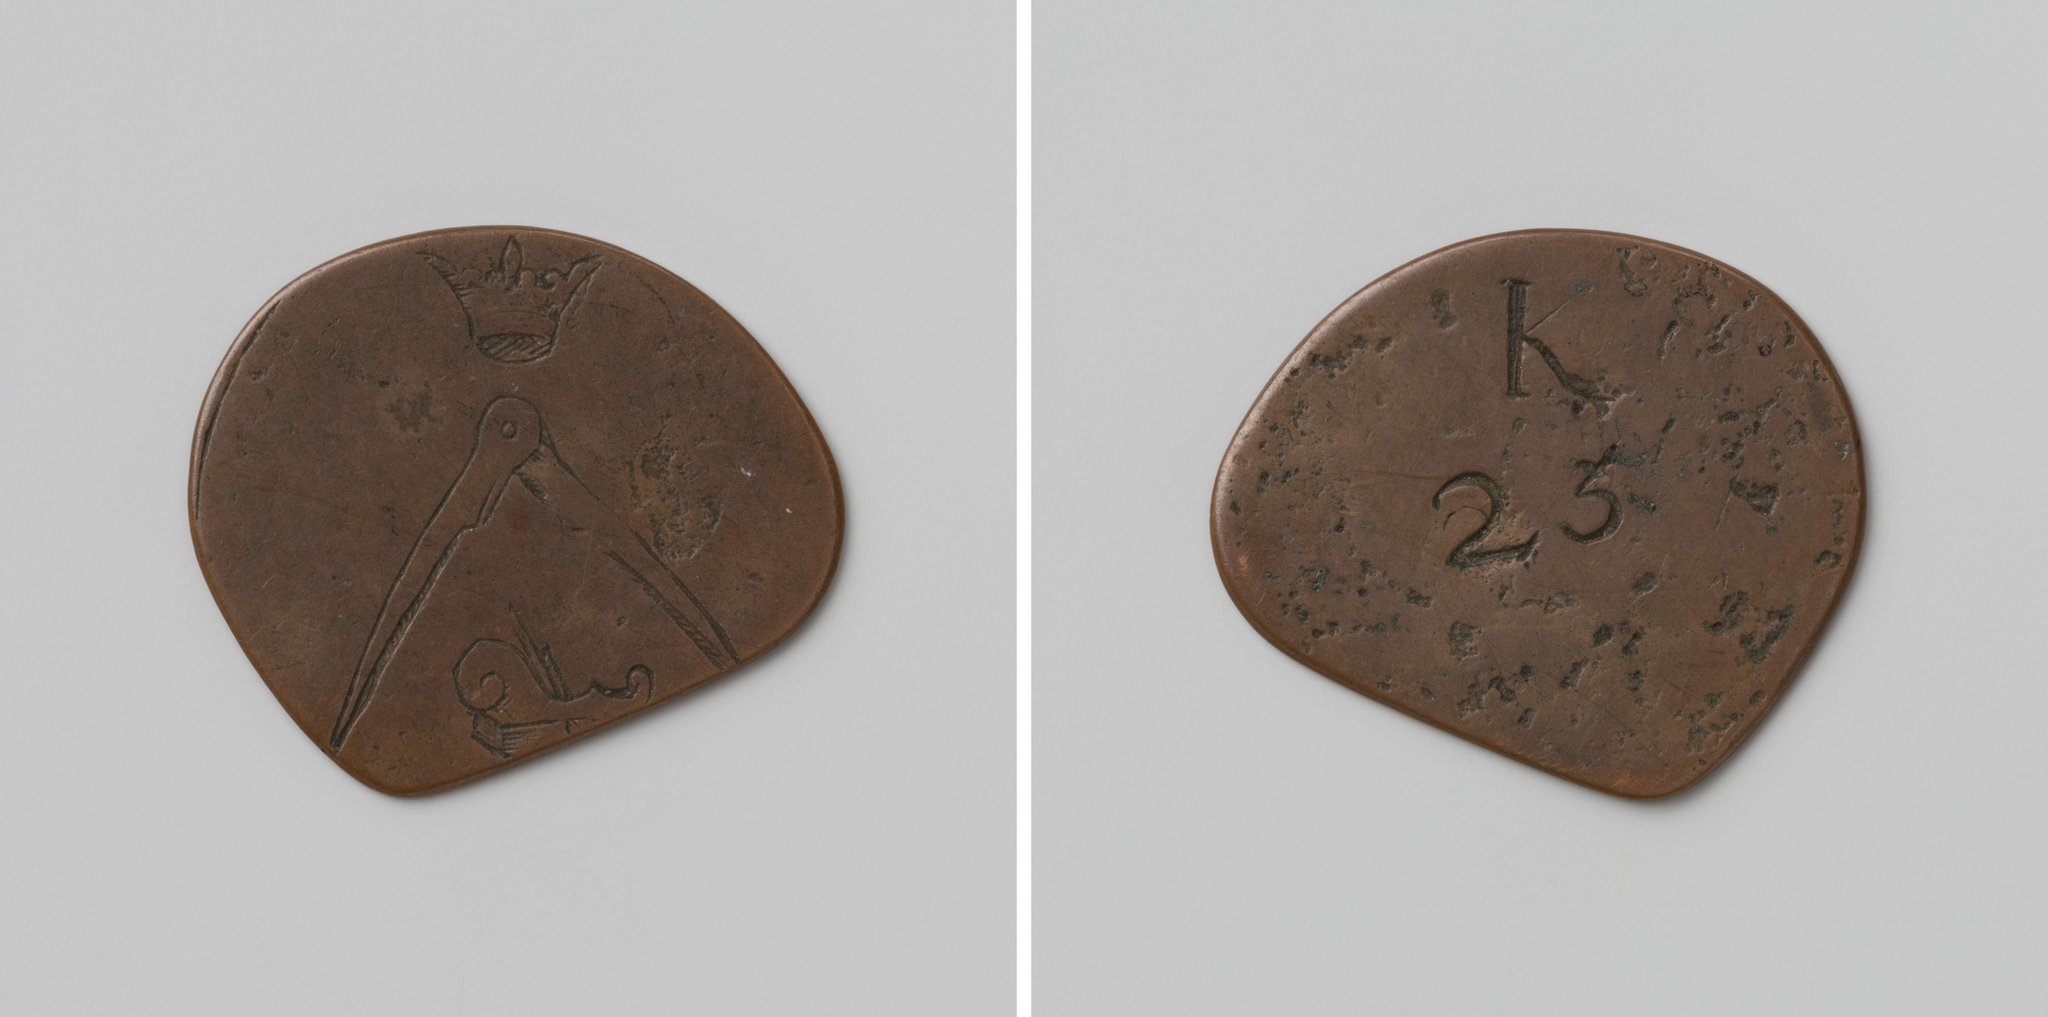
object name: medal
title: Timmerliedengilde, gildepenning met opschrift K 25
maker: Anonymous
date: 1600-1700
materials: copper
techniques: engraving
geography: kampen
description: Koperen penning waarvan rechtsonder gedeelte is afgesneden. Voorzijde: gekroonde, geopende passer boven schaaf. Keerzijde: opschrift